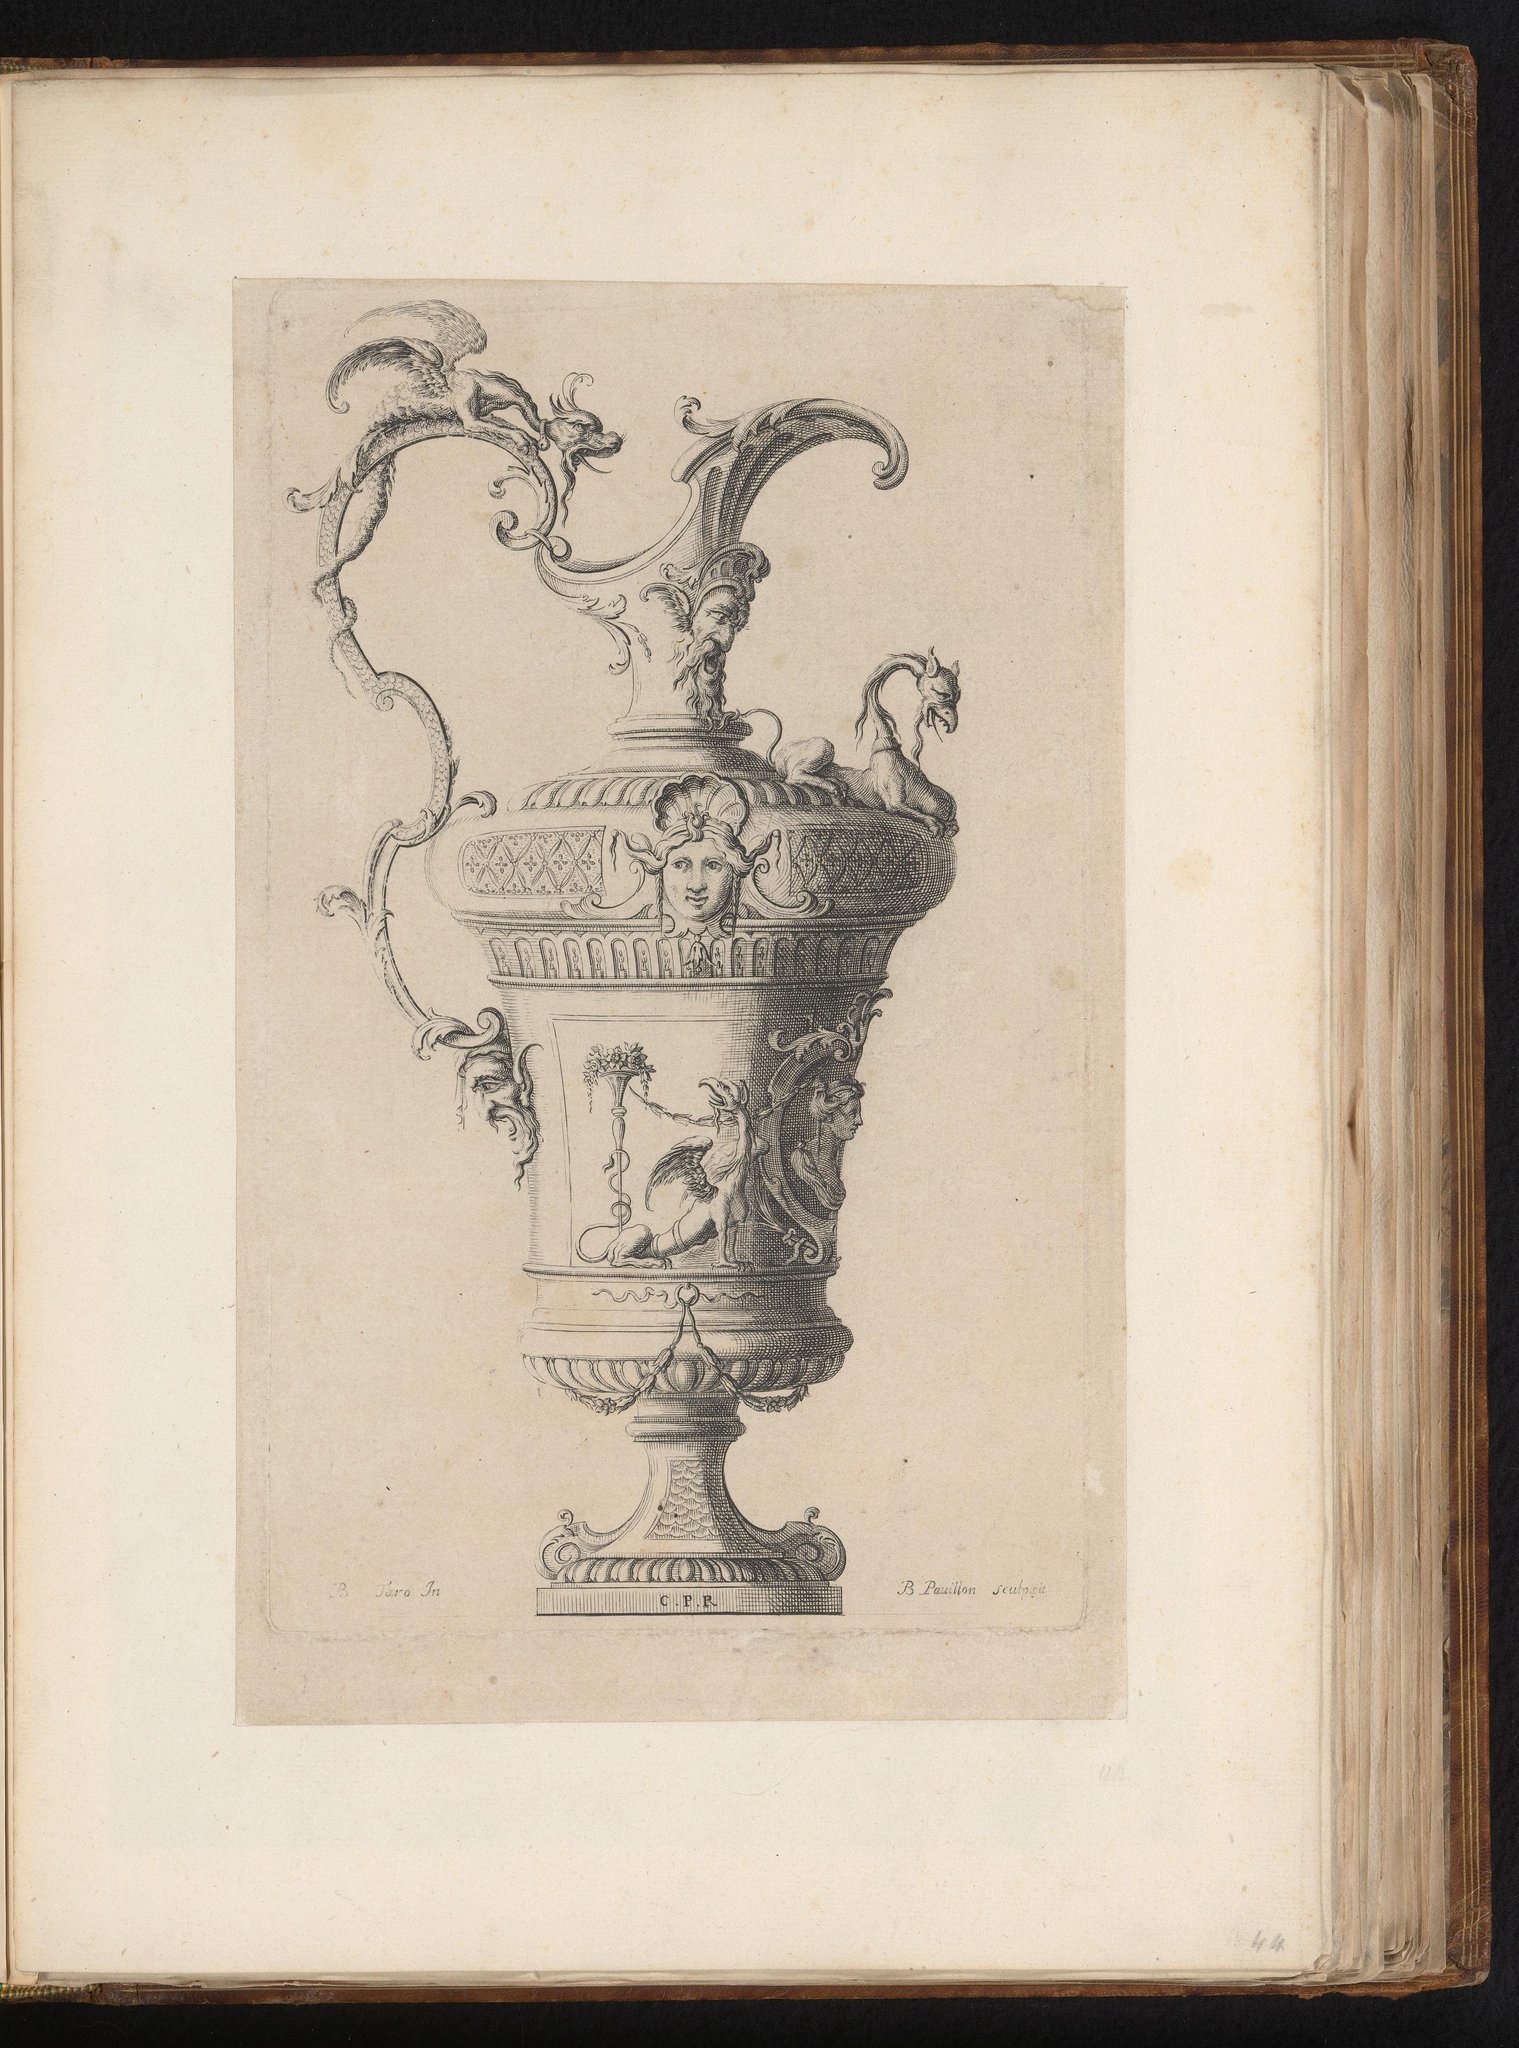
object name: print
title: Kan met draken en mascarons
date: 1682-1729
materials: paper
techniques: engraving, etching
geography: france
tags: dragon (large fabulous serpent, sometimes with wings and legs), vase ~ ornament, mask, mascaron ~ ornament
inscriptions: collector's mark: Lugt 2228, collector's mark: Lugt 2760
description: Prent maakt deel uit van een serie van zes prenten.